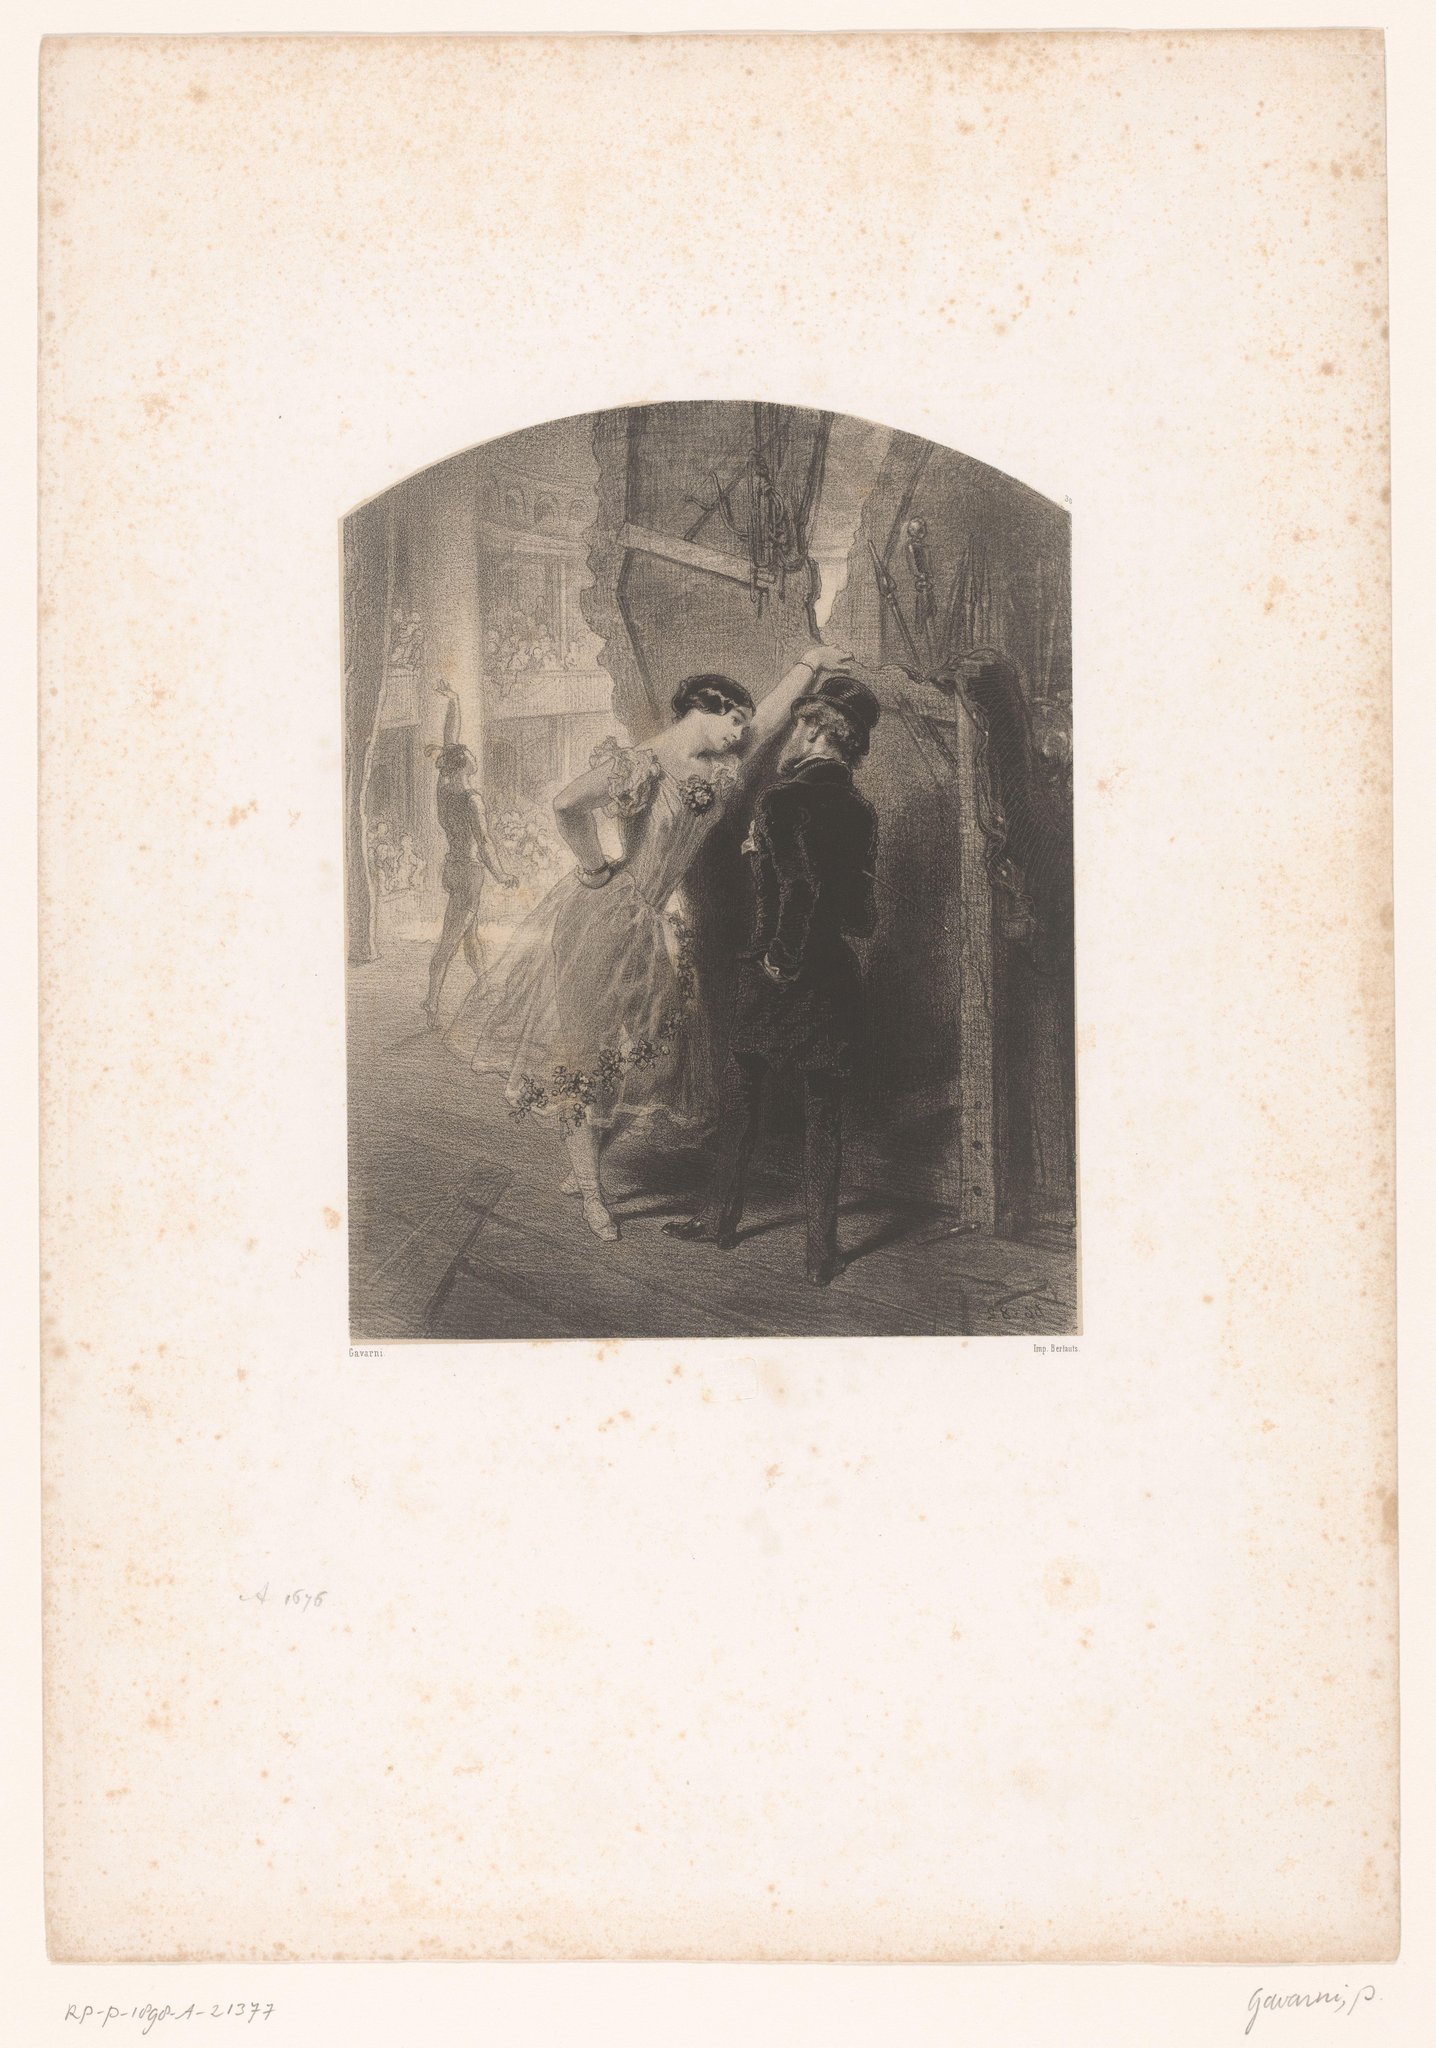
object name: print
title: Man praat met danseres achter het decor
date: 1847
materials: paper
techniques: lithograph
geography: paris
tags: behind the stage, female dancer, courting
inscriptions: check stamp: Lugt 36b, collector's mark: Lugt 964